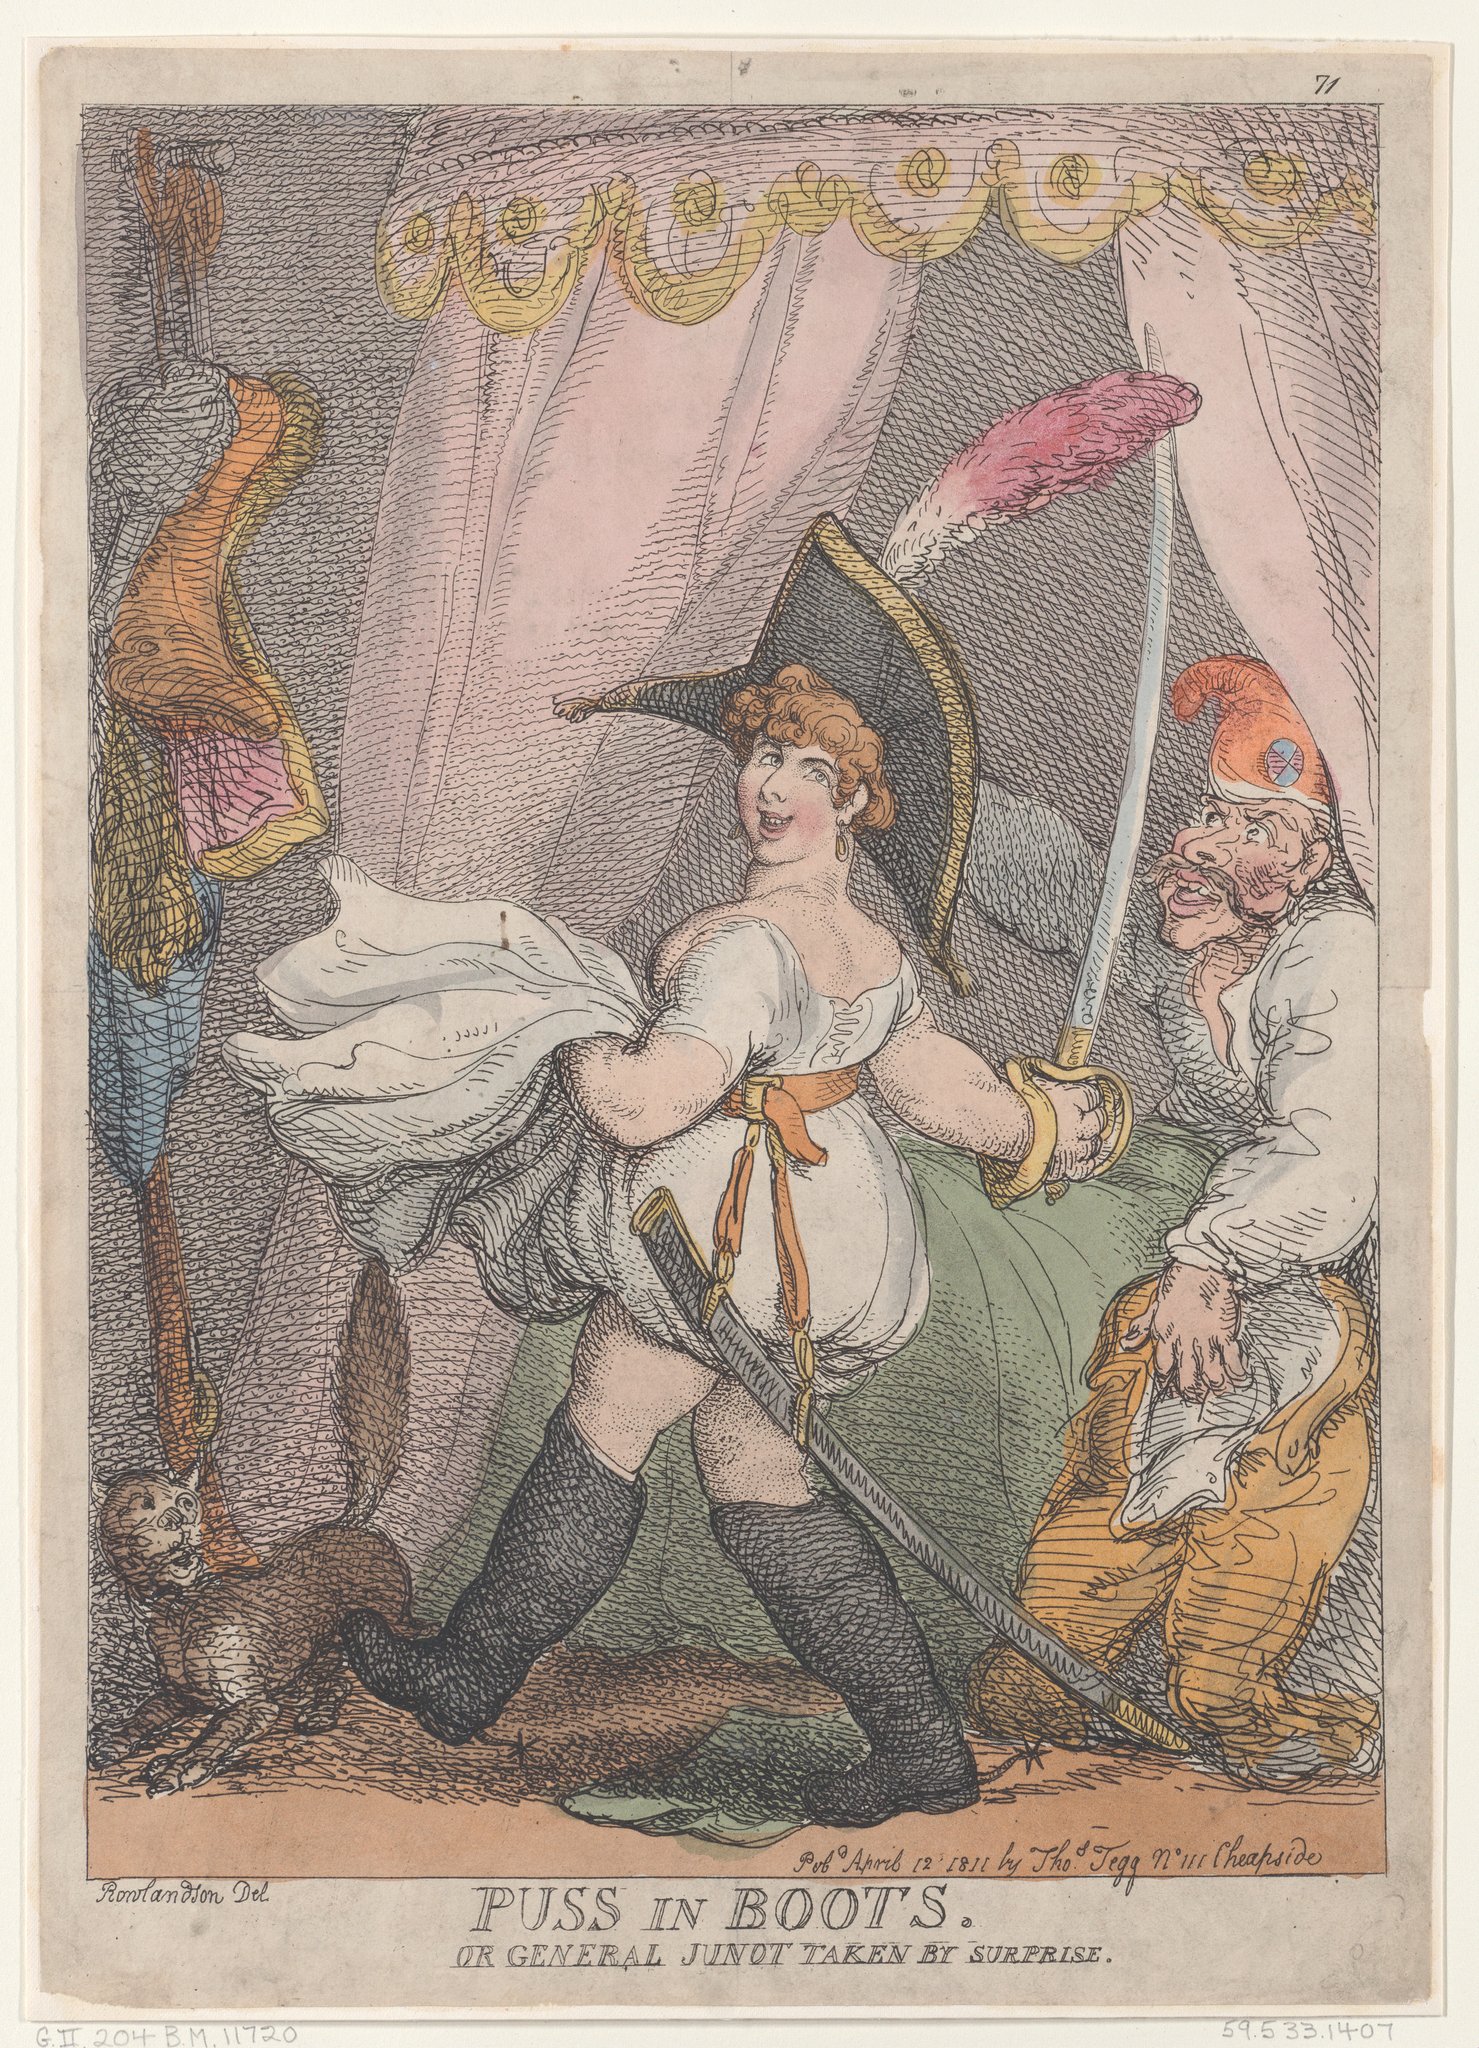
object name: print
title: Puss in Boots or General Junot Taken by Surprise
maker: thomas rowlandson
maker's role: artist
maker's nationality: british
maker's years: 1757-1827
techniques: etching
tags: satire,men,women,cats,beds